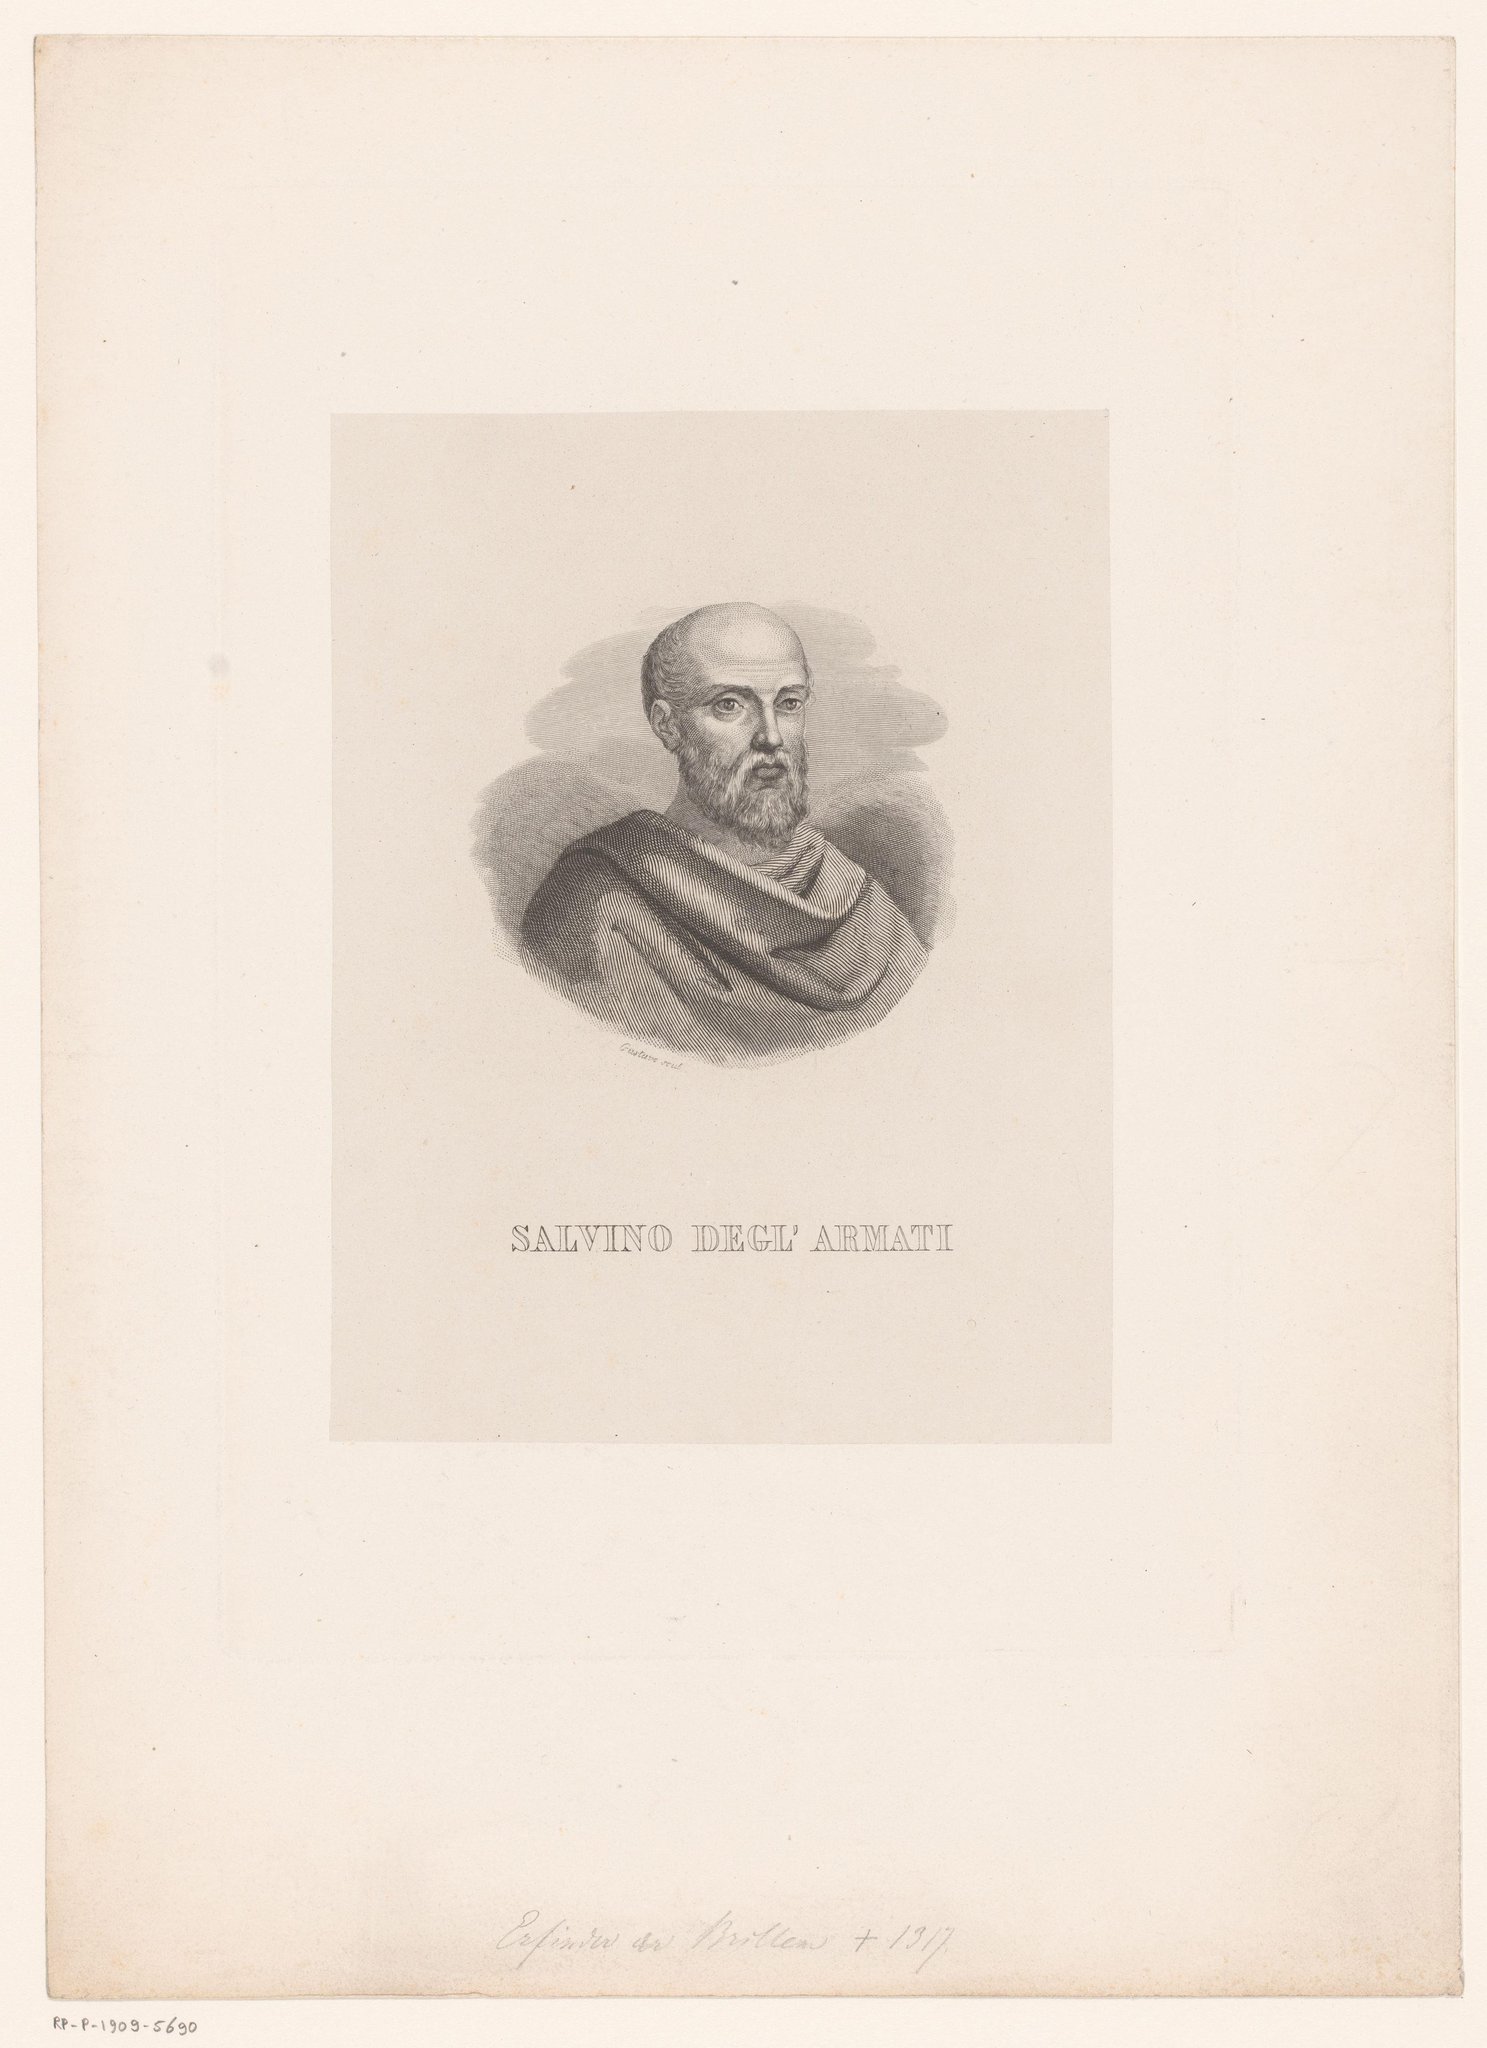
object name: print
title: Salvino Degl' Armati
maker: gustave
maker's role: print maker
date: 1800-1899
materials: paper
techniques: engraving, etching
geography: france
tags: historical persons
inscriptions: collector's mark: Lugt 2228